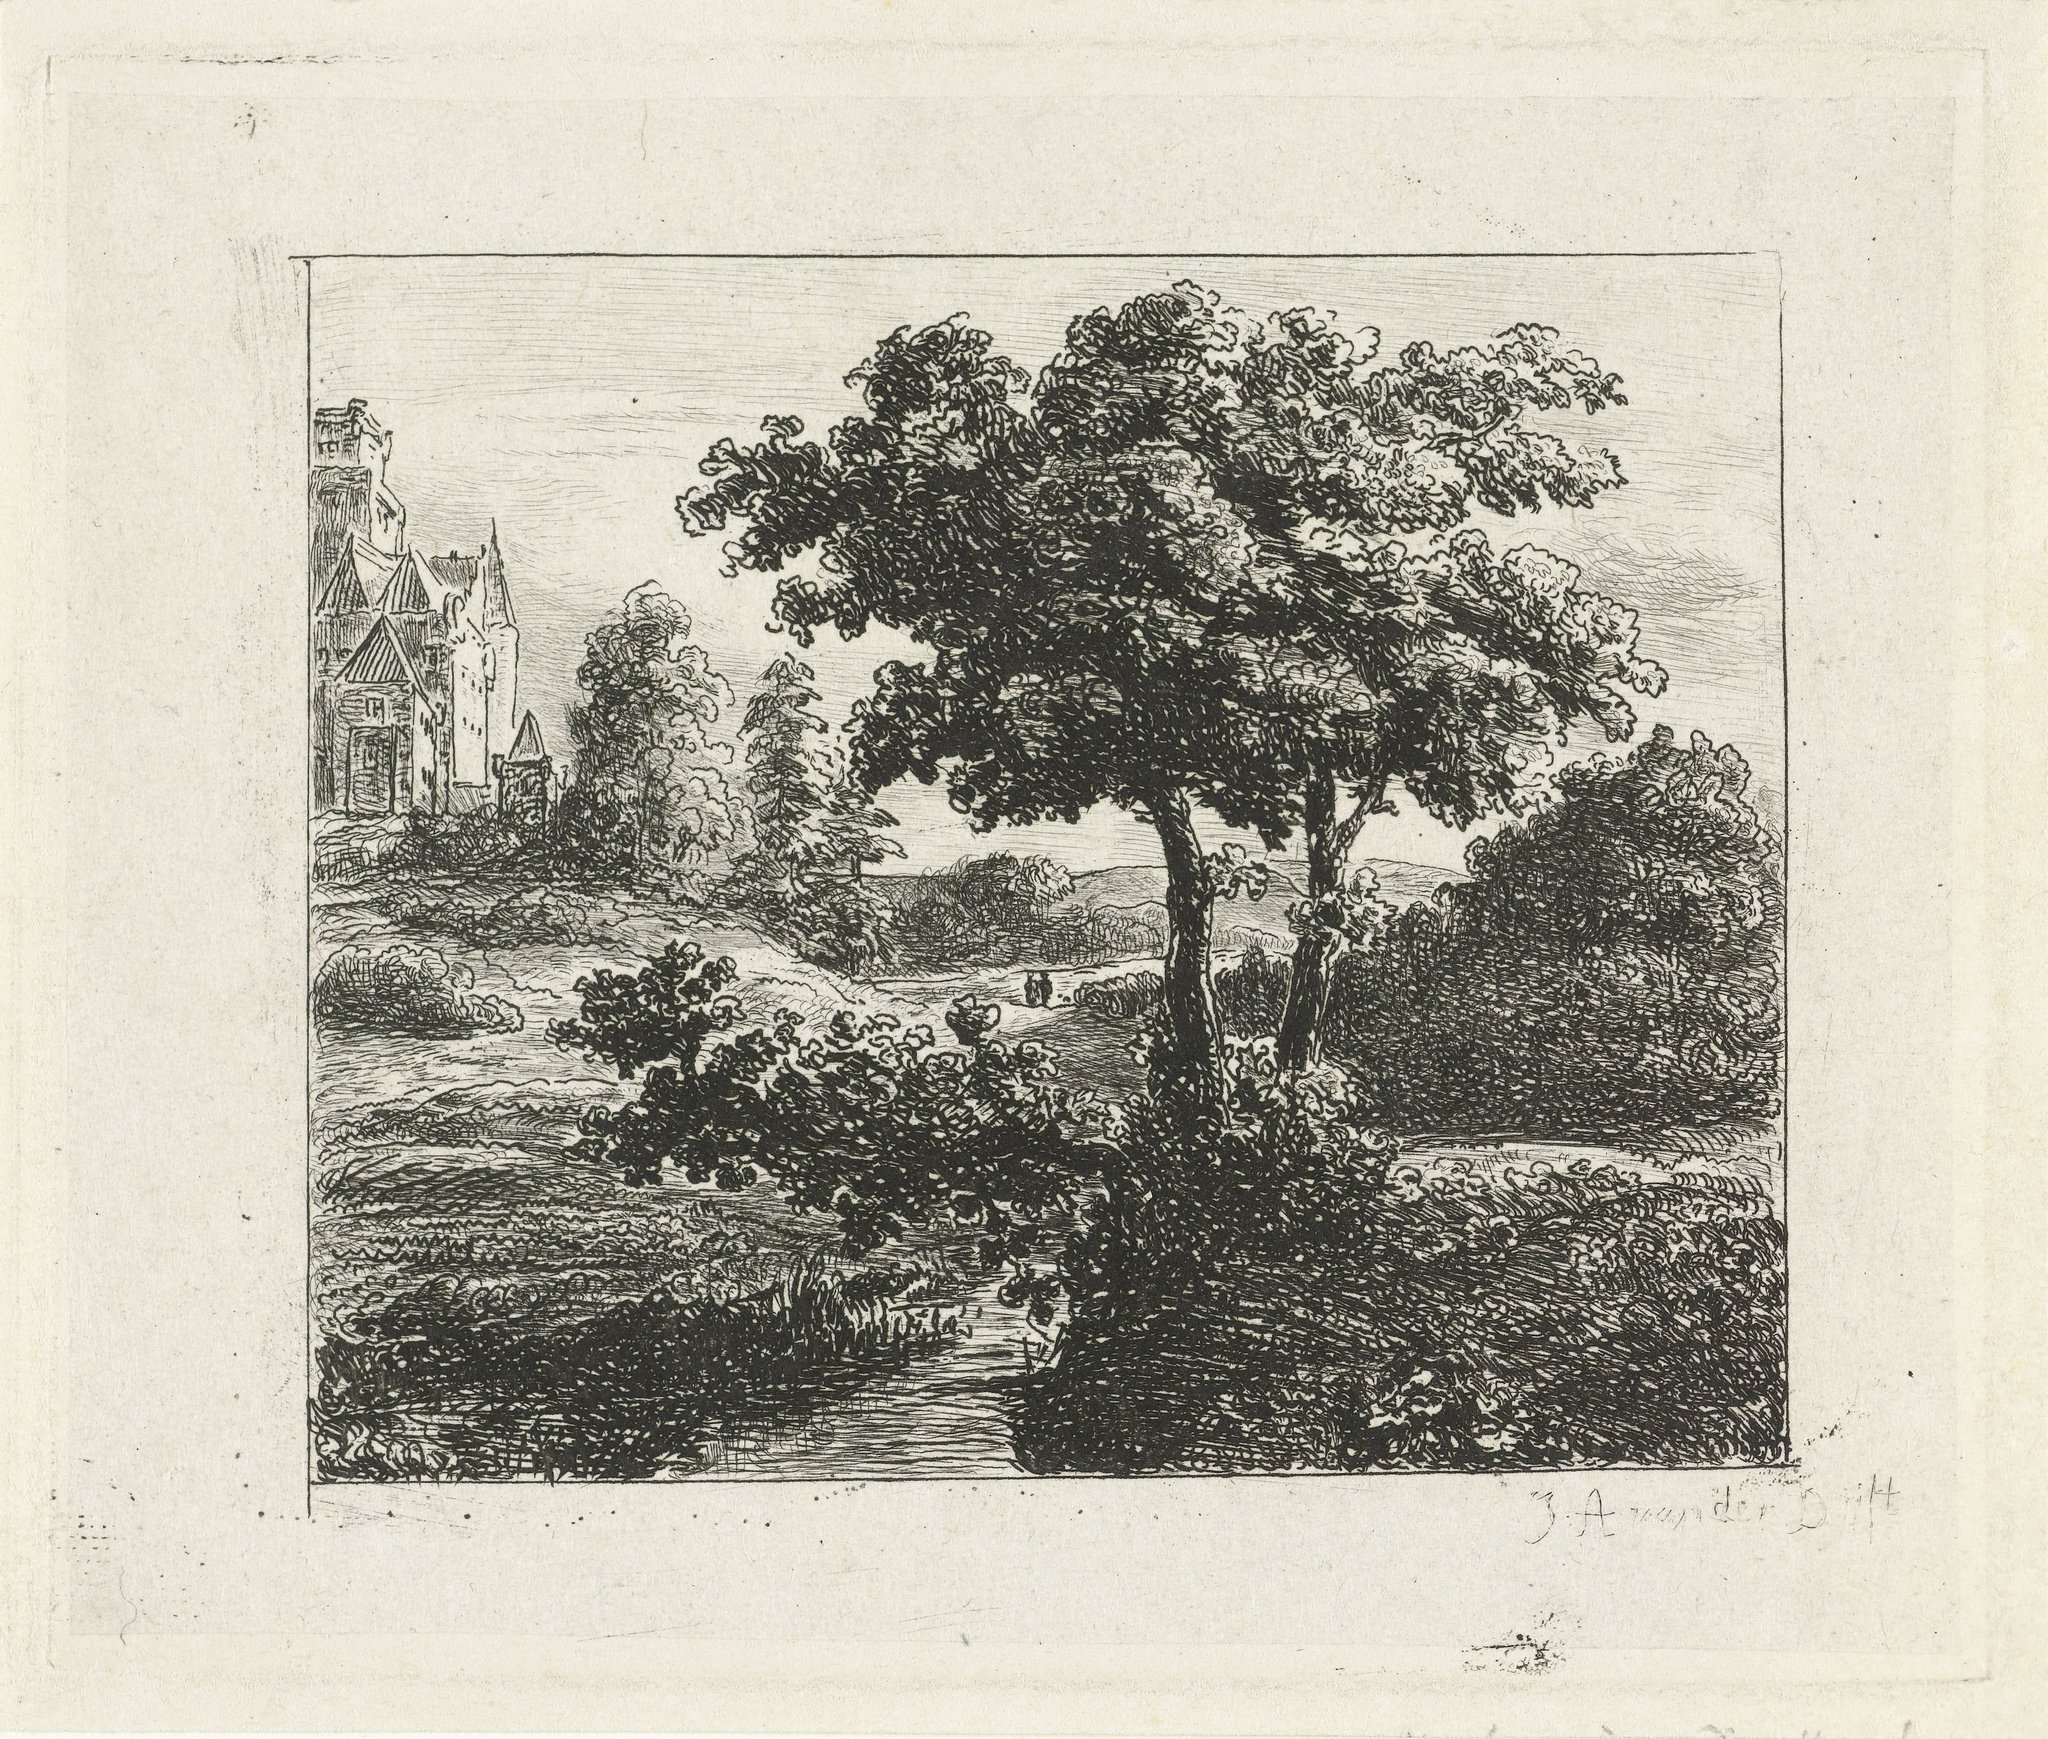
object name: print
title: Landschap met kerk op een heuvel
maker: johannes adrianus van der drift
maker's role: print maker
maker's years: 1808-1883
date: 1818-1882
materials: paper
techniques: etching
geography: netherlands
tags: landscape with other man-made constructions not mentioned above, e.g.: graveyards, playgrounds, etc.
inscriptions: collector's mark: Lugt 2228